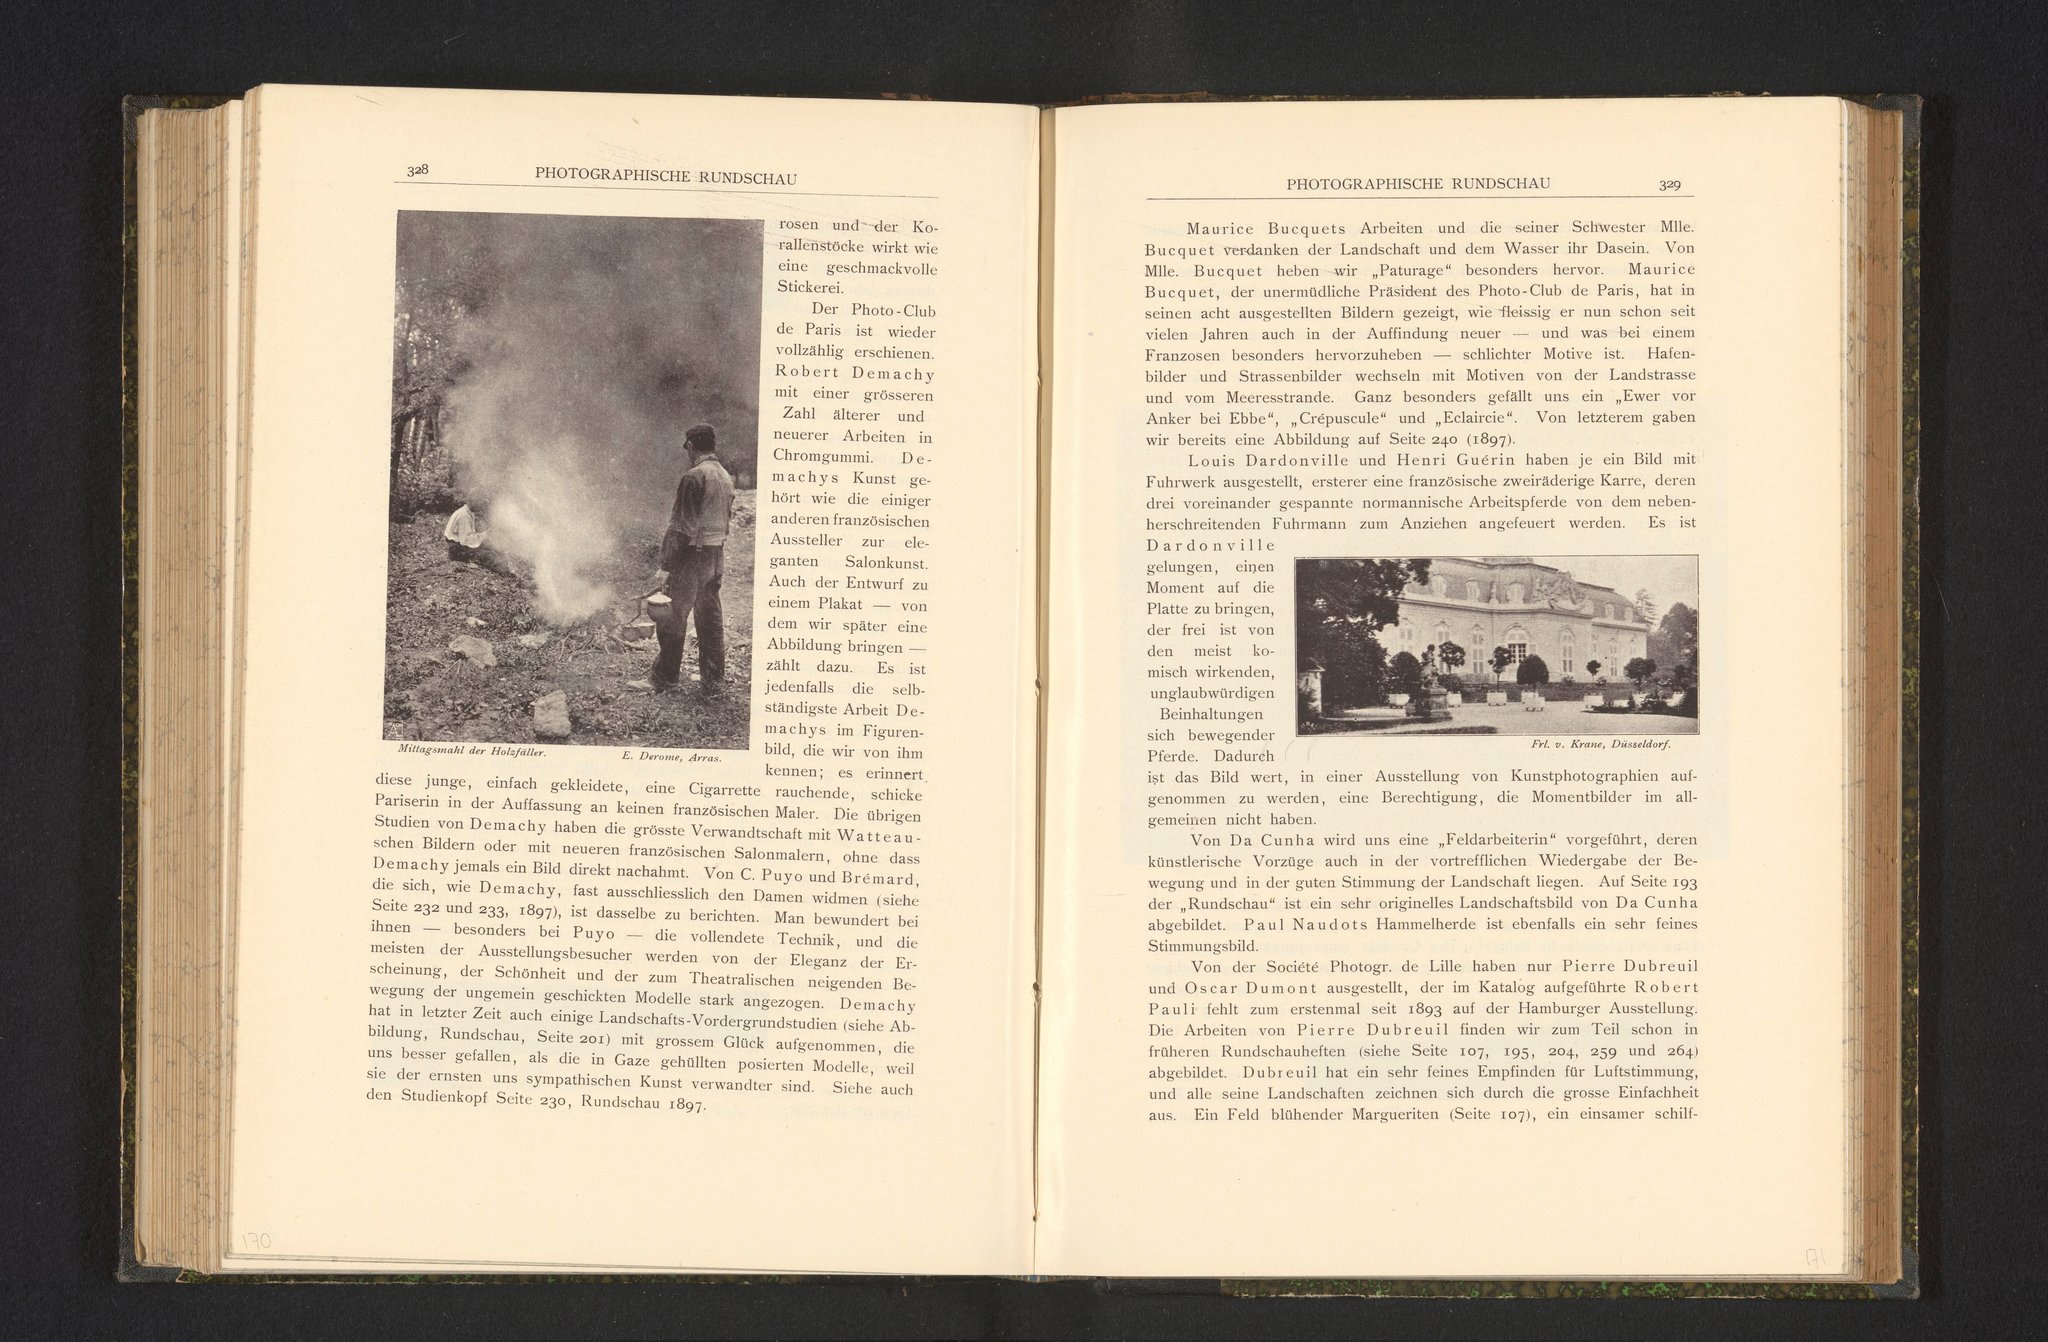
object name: page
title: Een houthakker voor een vuur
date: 1893-1898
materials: paper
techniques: autotype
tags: woodcutting, woodcutter ~ forestry, camp-fire; watch-fire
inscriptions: monogram: ‘drAco’